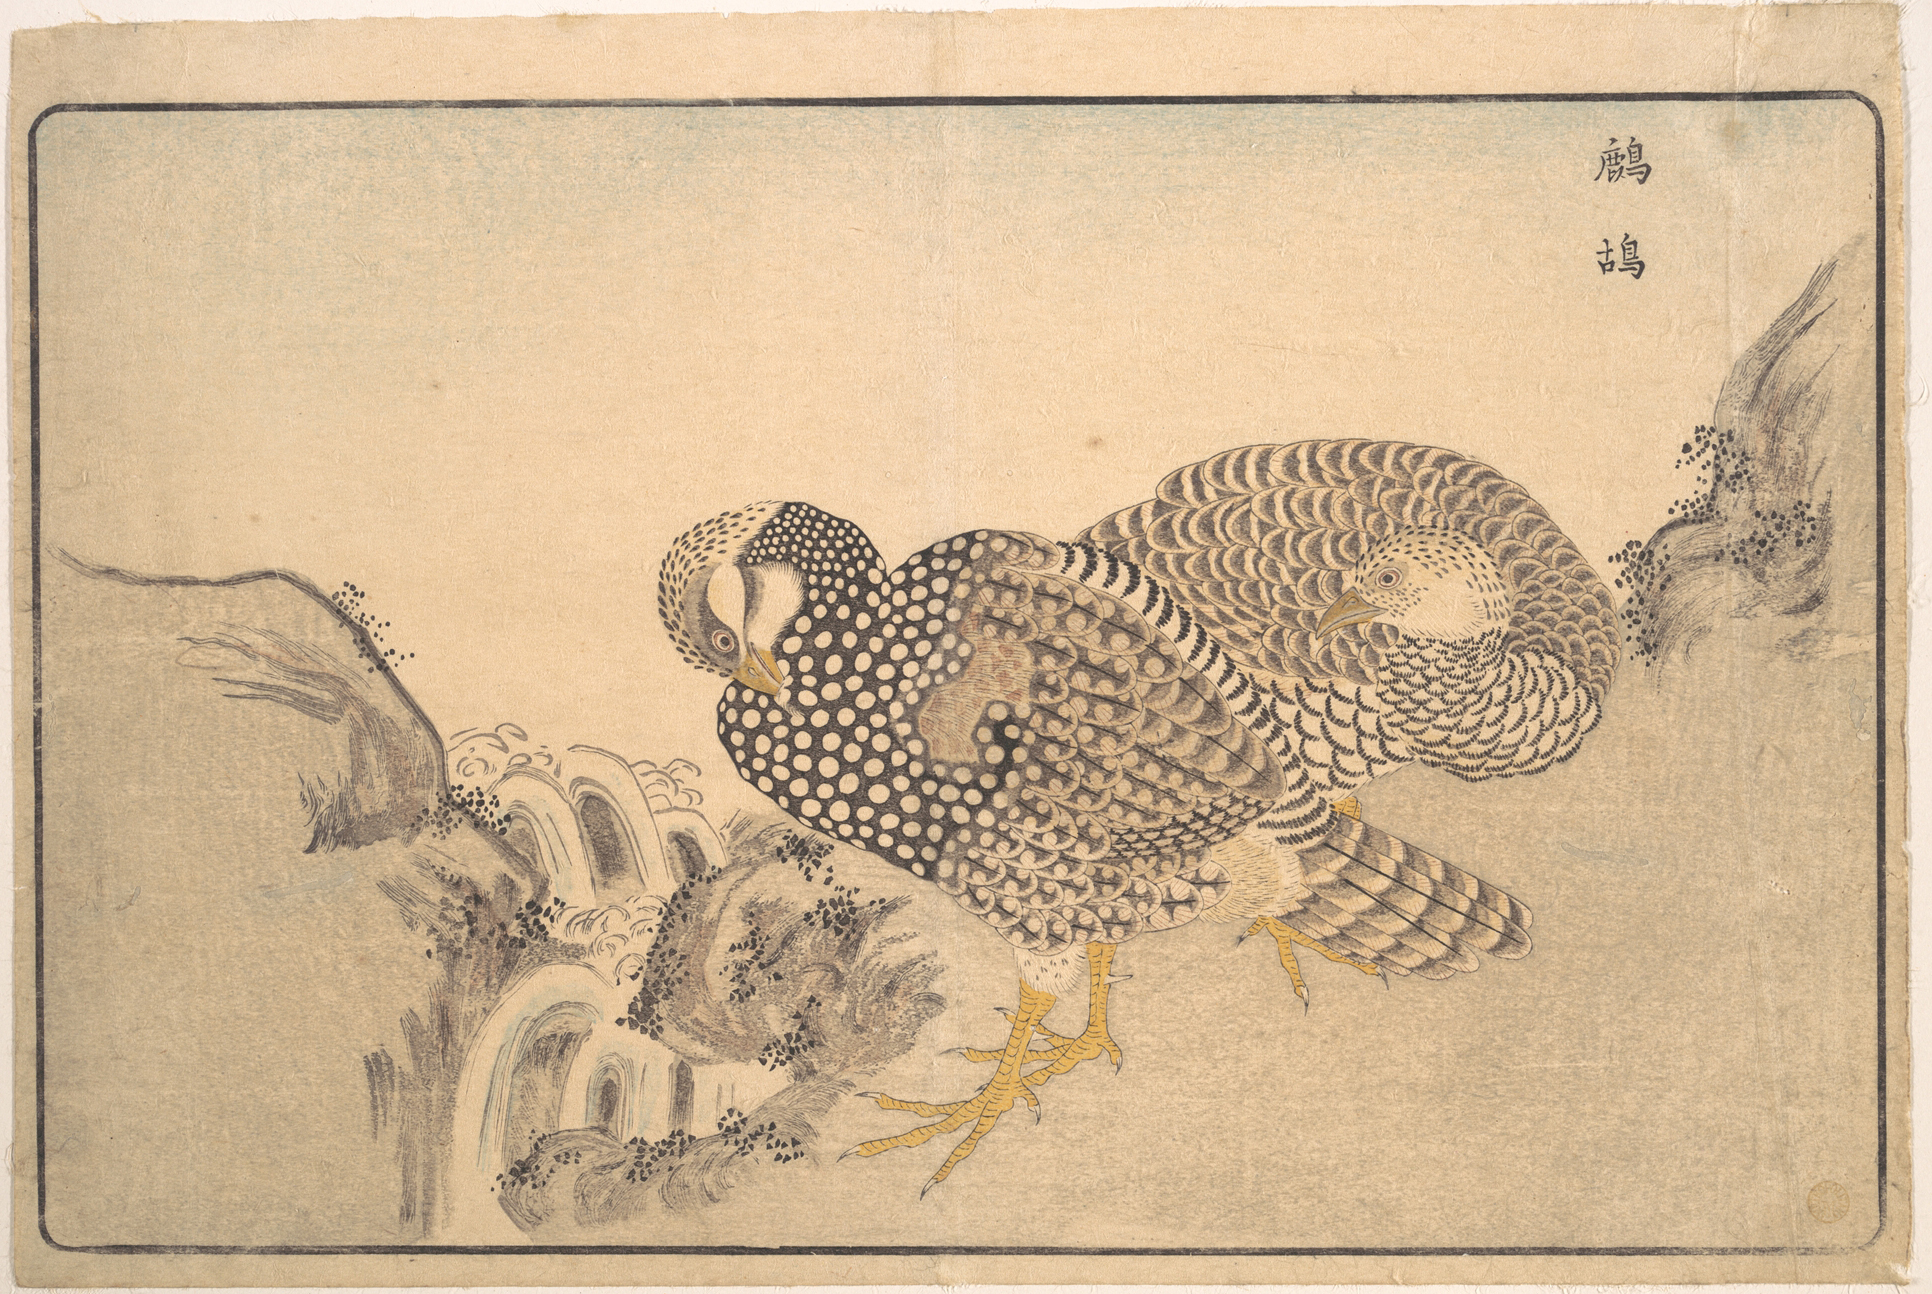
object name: print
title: Zhe gu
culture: japanese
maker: kuwagata keisai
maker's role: artist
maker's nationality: japanese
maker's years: 1764-1824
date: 1789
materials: ink, paper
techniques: woodblock print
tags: pheasants